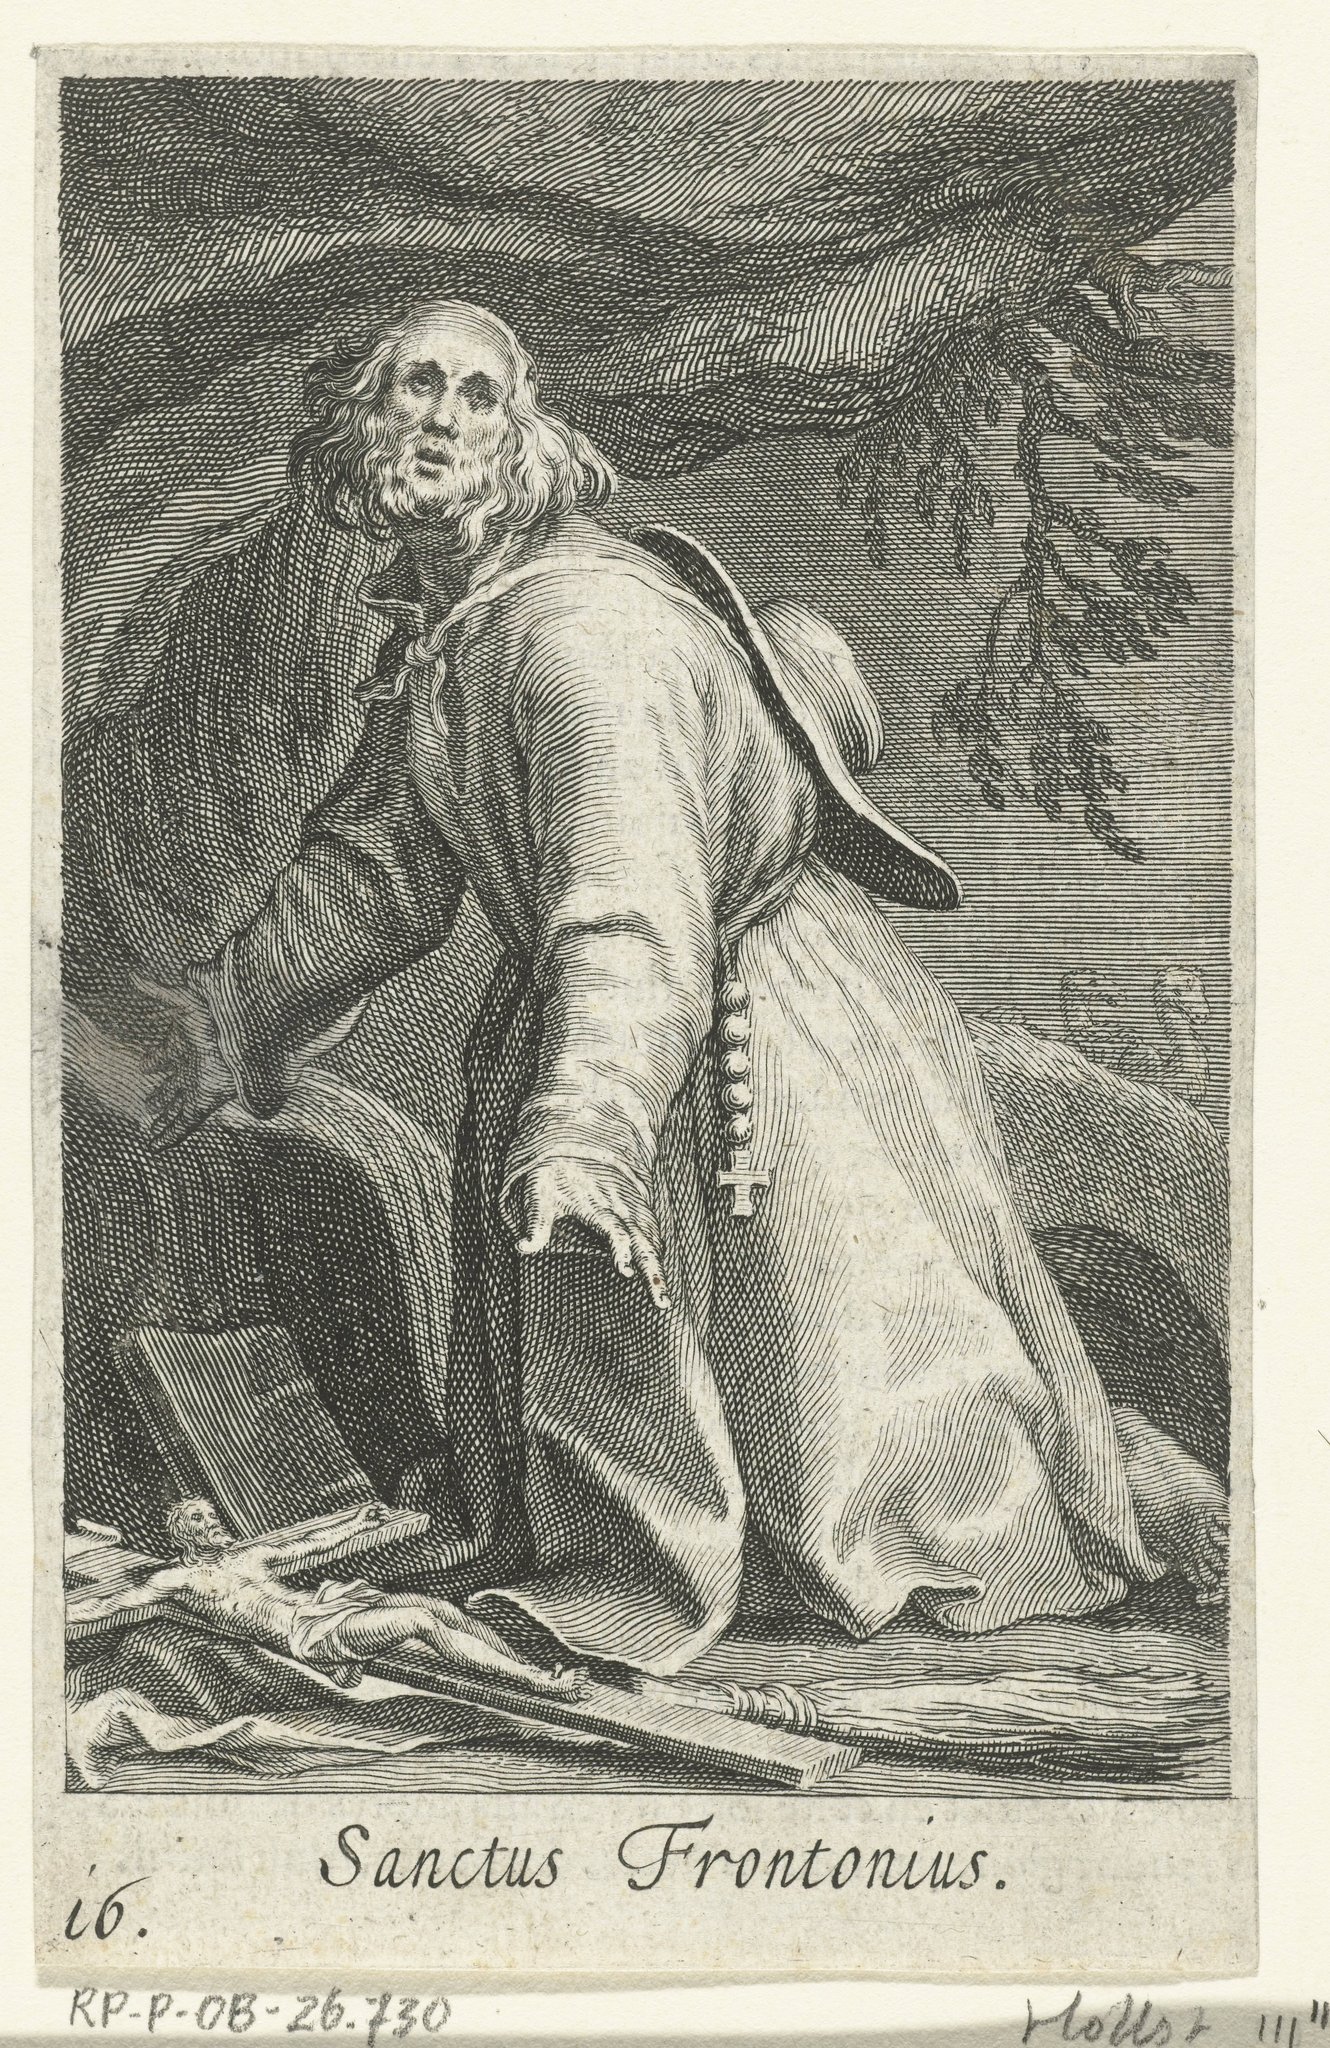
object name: book illustration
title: Sacra eremvs ascetarvm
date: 1590-1612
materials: paper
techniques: engraving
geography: low countries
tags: saints, anchorite, hermit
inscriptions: collector's mark: Lugt 2228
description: Prent uit: Sacra eremus ascetarum, Antwerpen, Hendrick Aertssen, 1619. Eerste gebonden uitgave met in totaal vijftig prenten. Prent uit serie van vijfentwintig mannelijke kluizenaars. In 1612 verscheen een ongebonden editie maar op basis van de gewijzigde opschriften en samenstelling wordt aangenomen dat de prenten van de uitgave 1619 ook in 1612 of iets daarvoor gedrukt werden. Roethlisberger beschouwt de uitgave van 1619 als de eerste staat en de ongebonden editie van 1612 als de tweede staat (Roethlisberger 1993, p. 171, 172).